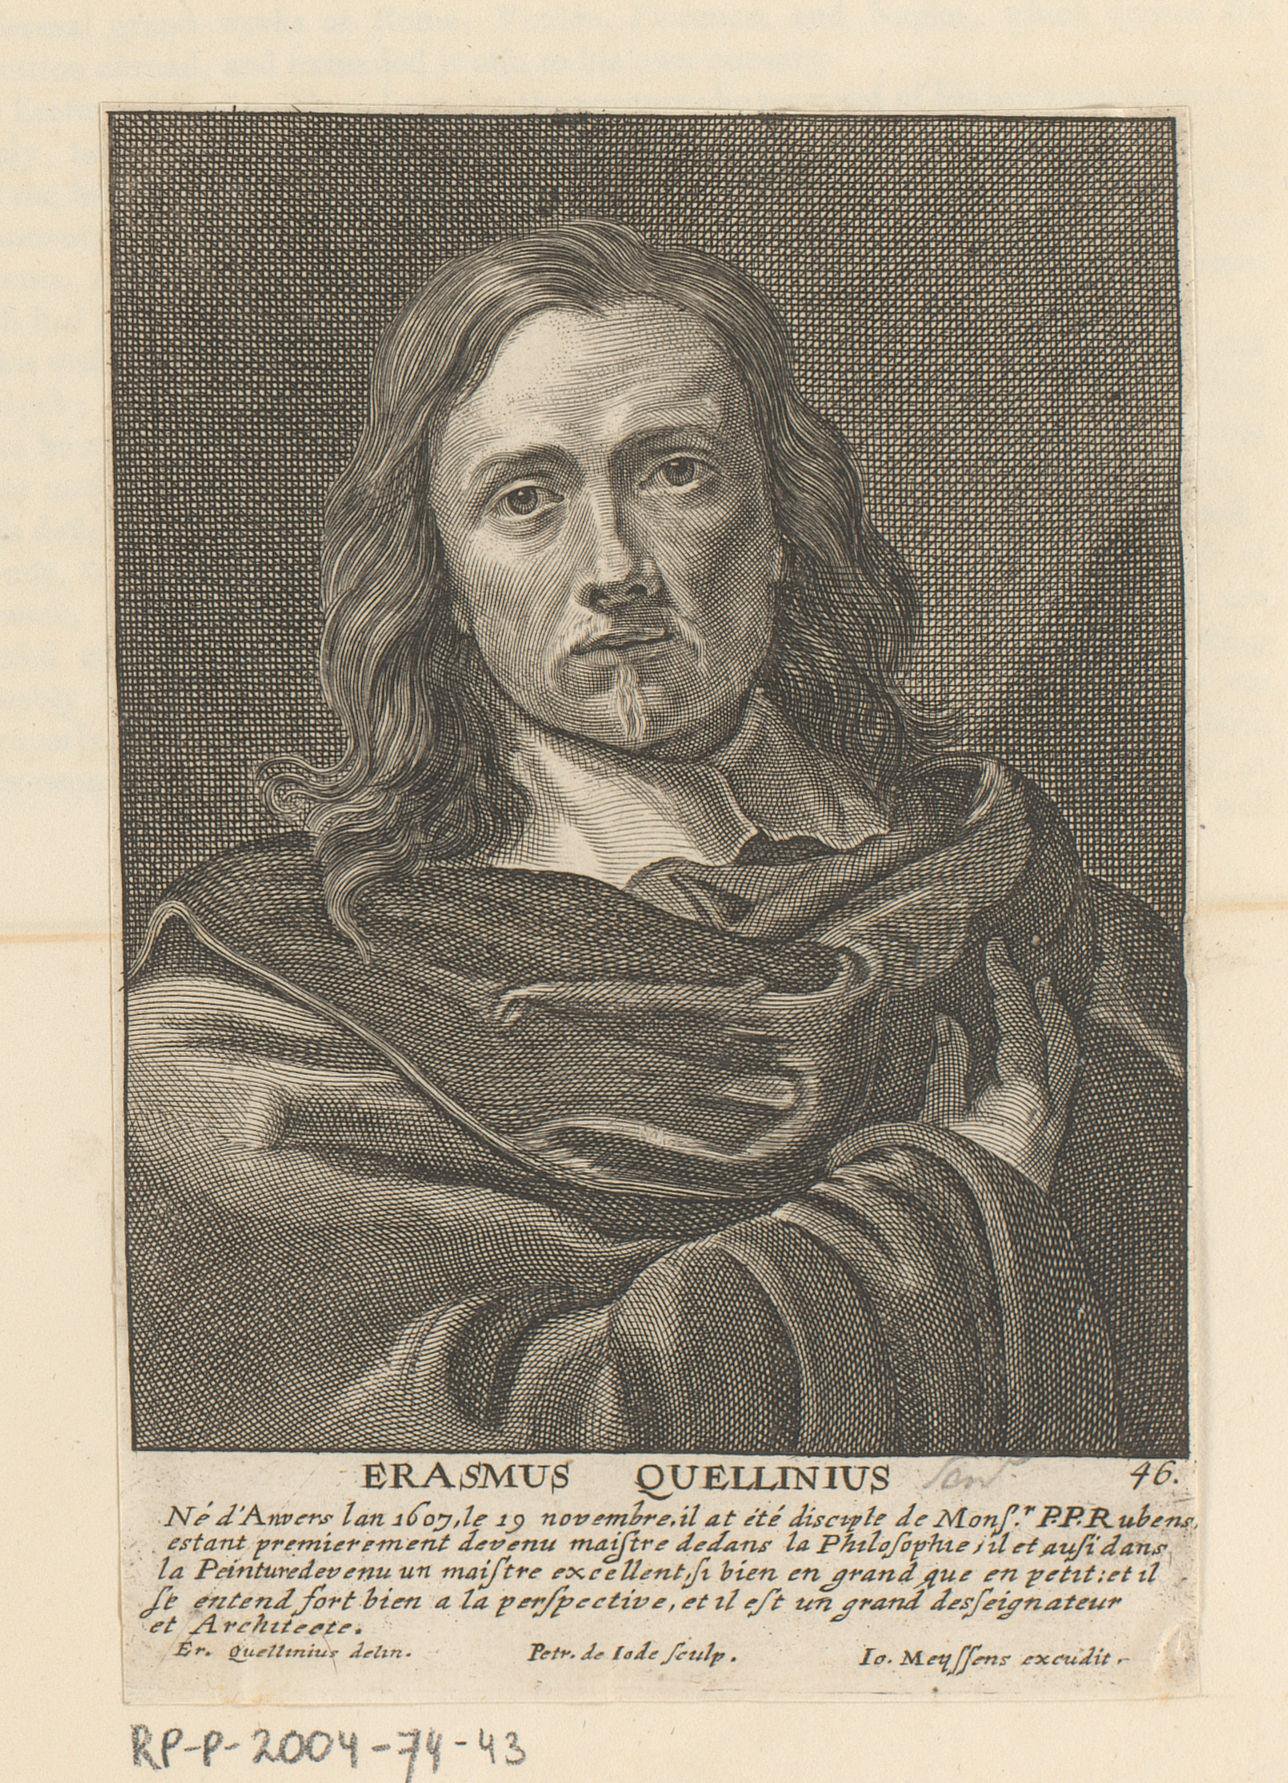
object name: print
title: Erasmus Quellinius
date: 1649-1662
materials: paper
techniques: engraving, etching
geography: antwerp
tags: antwerp, print maker, draughtsman, erasmus quellinus (ii), historical persons, portrait, self-portrait of painter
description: Prent mogelijk uit: Meyssens, Joannes. Image de divers hommes desprit sublime qui par leur art et science deburovent vivre eternellement et des quels la louange et renommée faict estonner le monde. 2 dln. Antwerpen: Joannes Meyssens, 1649, dl. 1, p. 34. De samensteller heeft deze prent in het album geplakt als illustratie bij: Pilkington, Matthew en Johann Heinrich Füssli. A dictionary of painters, from the revival of the art to the present period. 4 dln. Londen: John Crowder, 1805, dl. 3, p. 411.